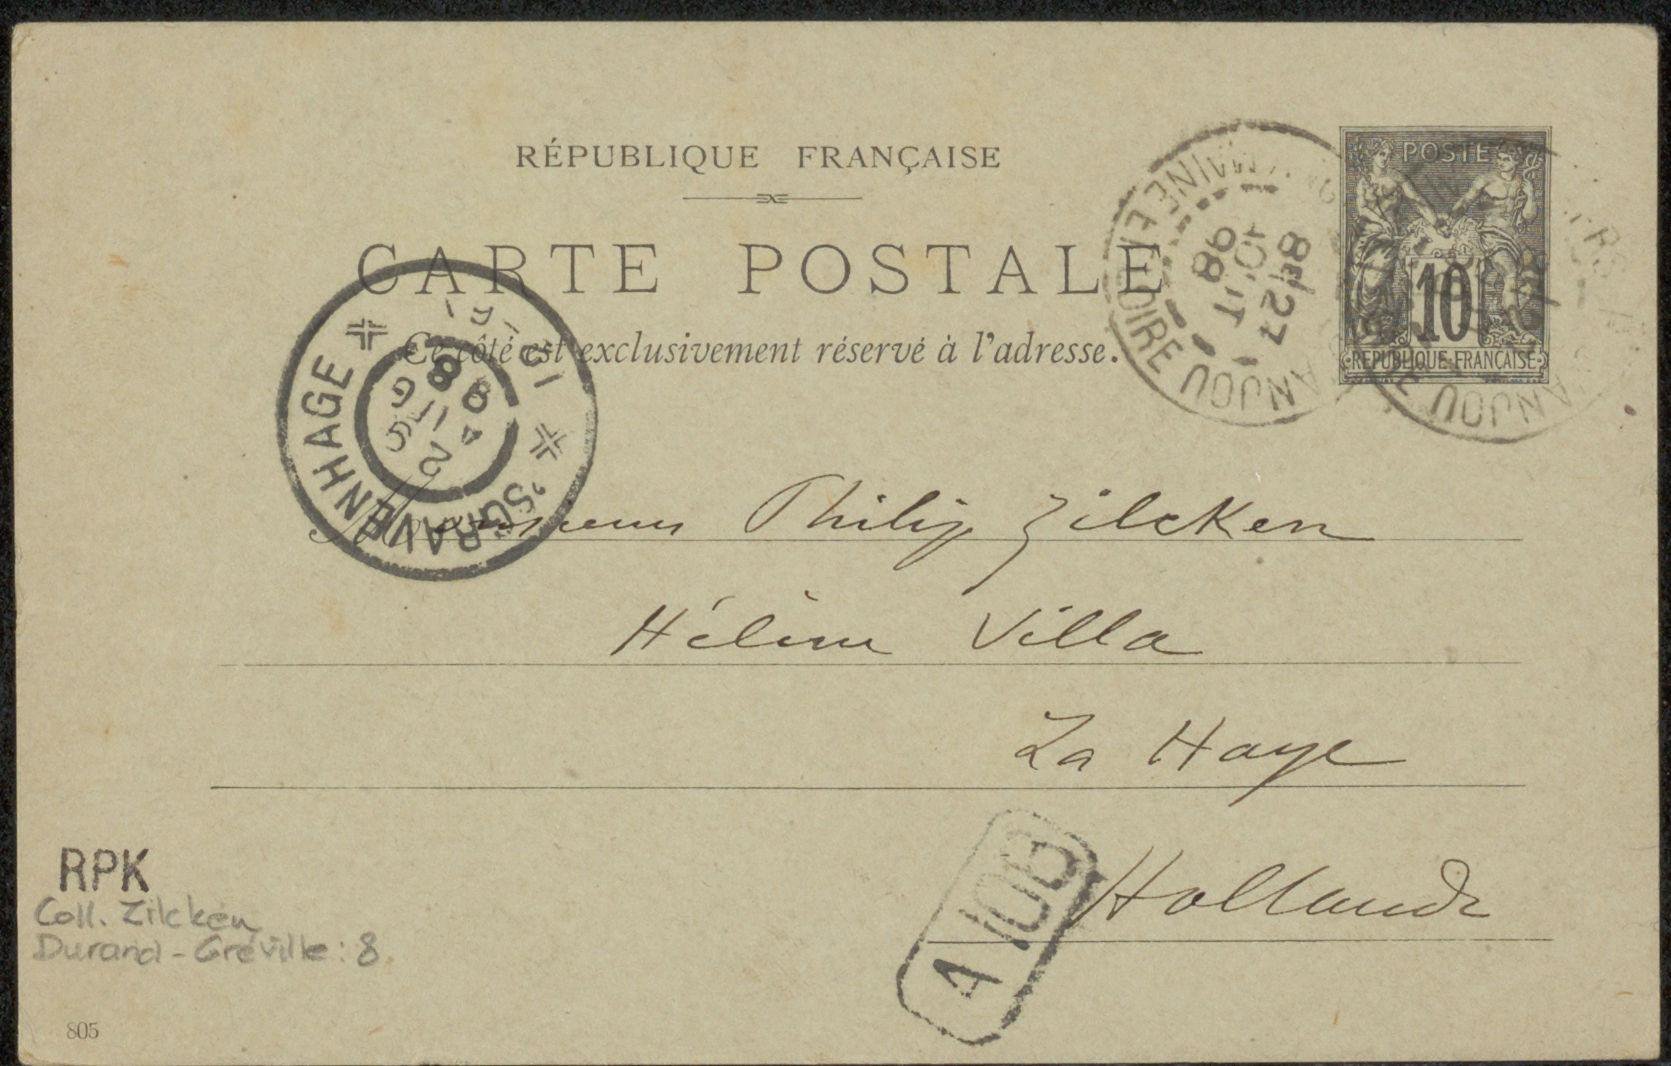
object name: postcard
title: Briefkaart aan Philip Zilcken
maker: émile durand-gréville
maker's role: schrijver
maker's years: 1838-1914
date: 1898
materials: cardboard, ink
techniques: pen, writing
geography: angers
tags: the hague, painter, draughtsman, philip zilcken, photography, cinematography, the graphic arts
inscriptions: collector's mark: ‘RPK’